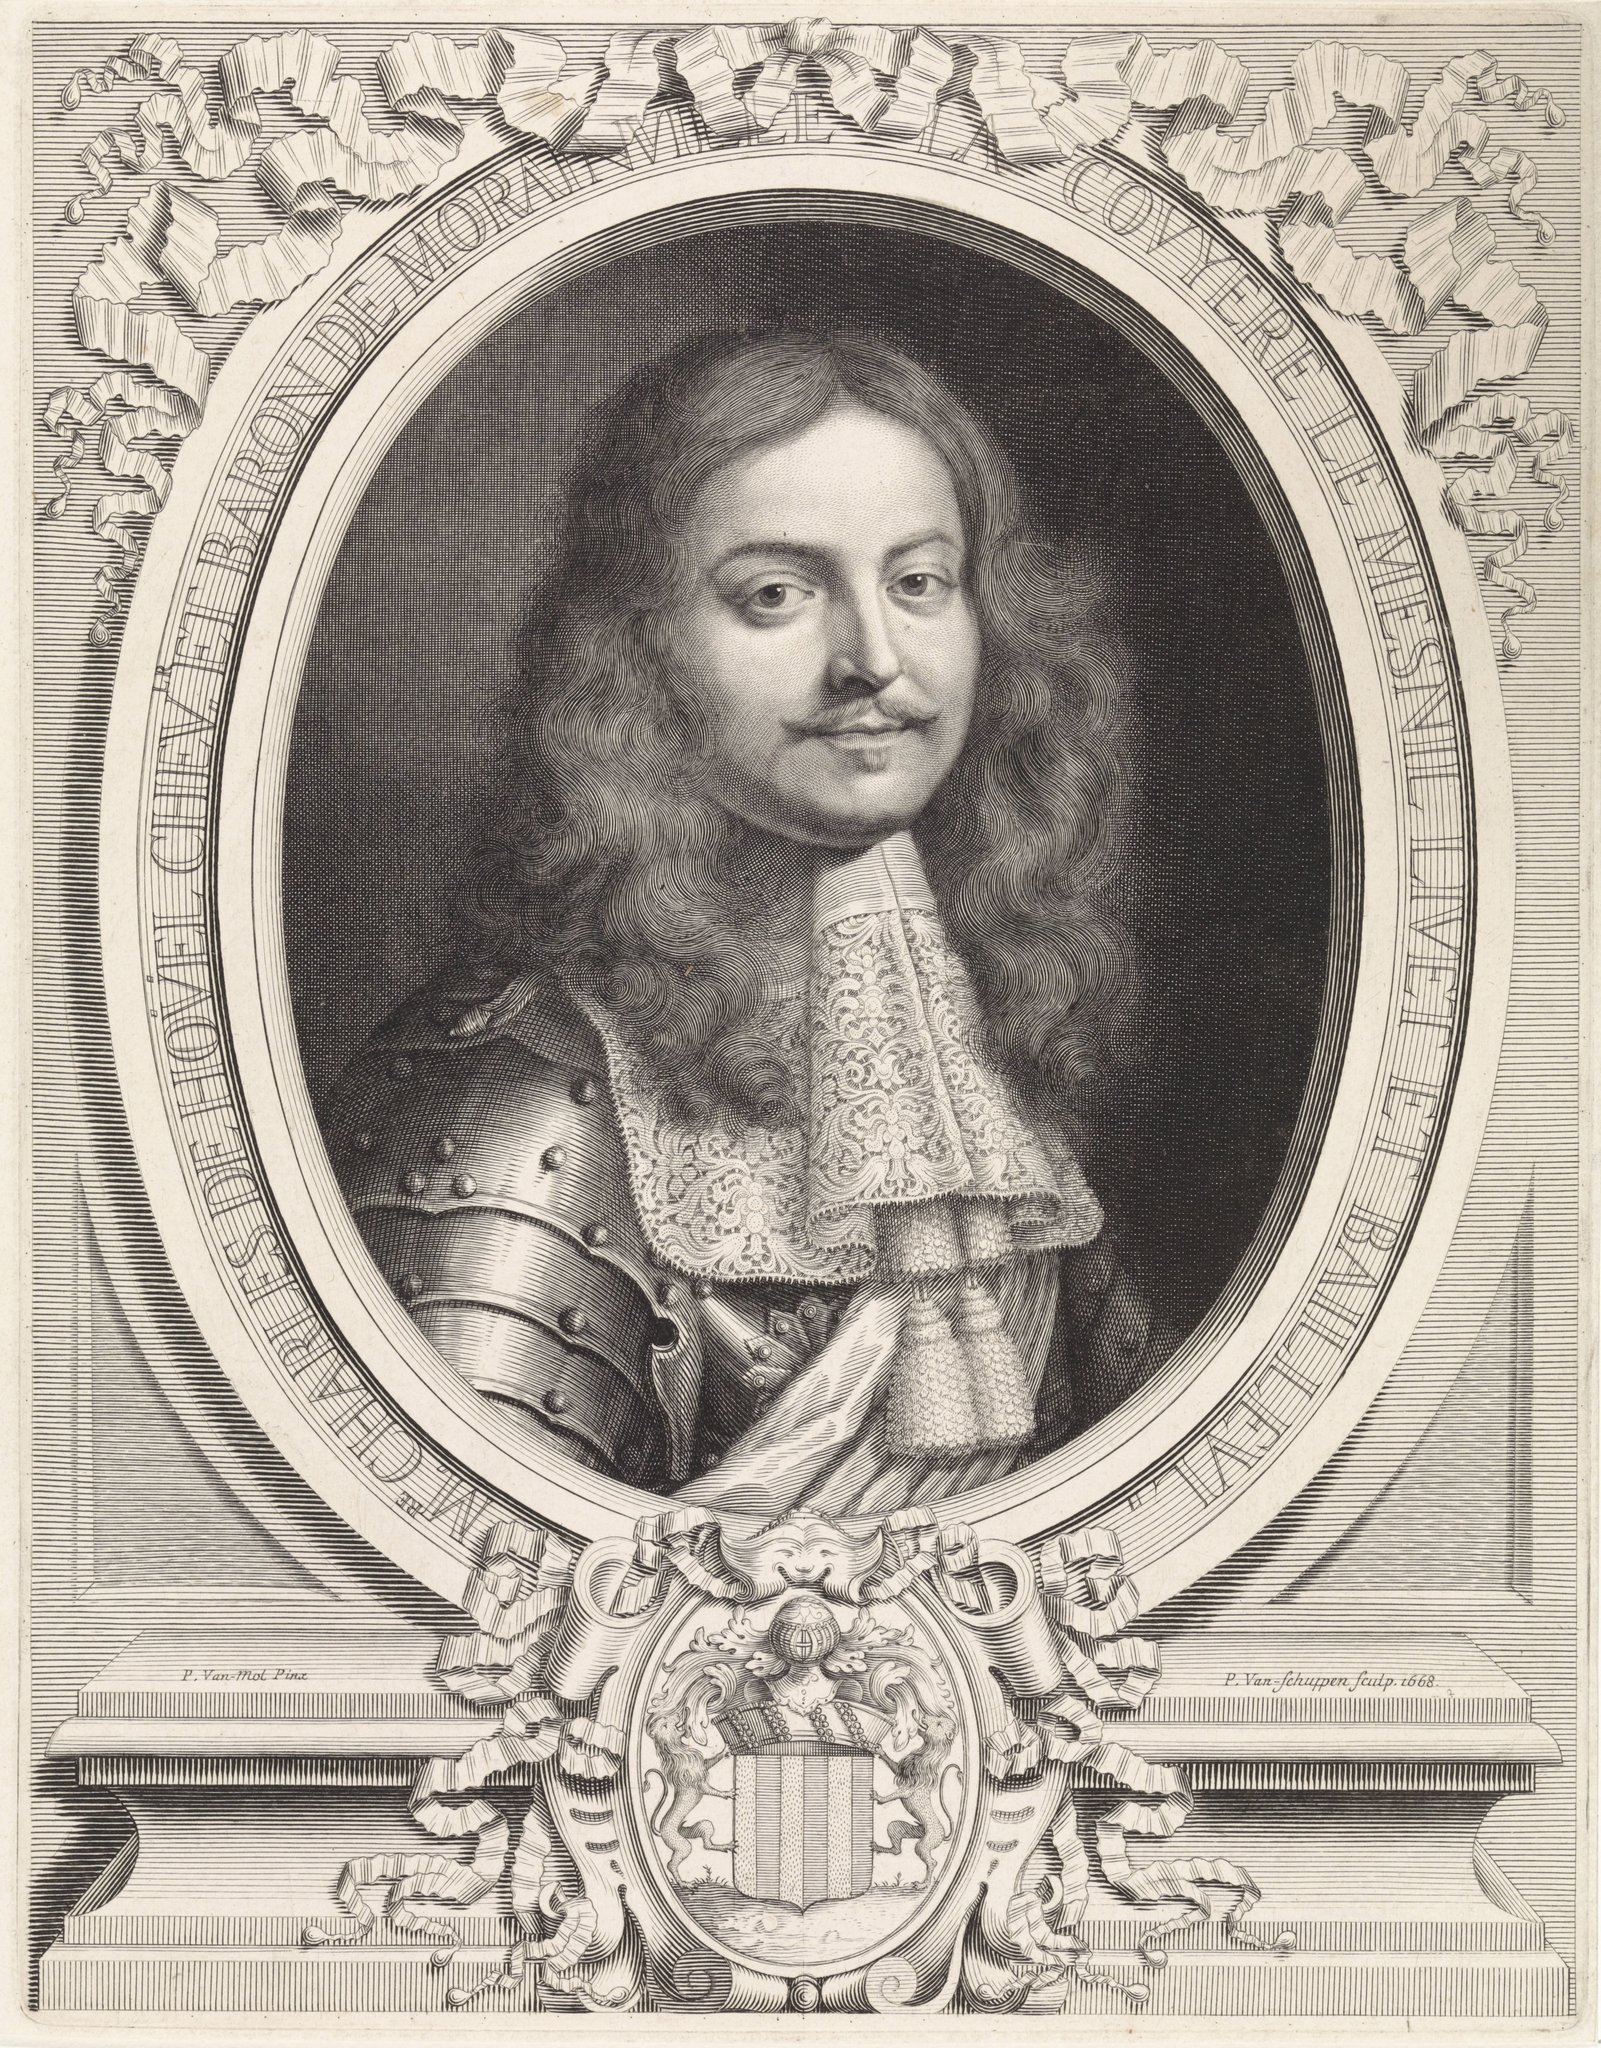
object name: print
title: Portret van Charles de Hoüel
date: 1602-1668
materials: paper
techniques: engraving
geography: paris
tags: charles de hoüel de morainville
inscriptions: collector's mark: Lugt 2228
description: Portret van baron Charles de Hoüel de Morainville in harnas met kanten kraag en kwasten. Op het piëdestal zijn wapenschild.